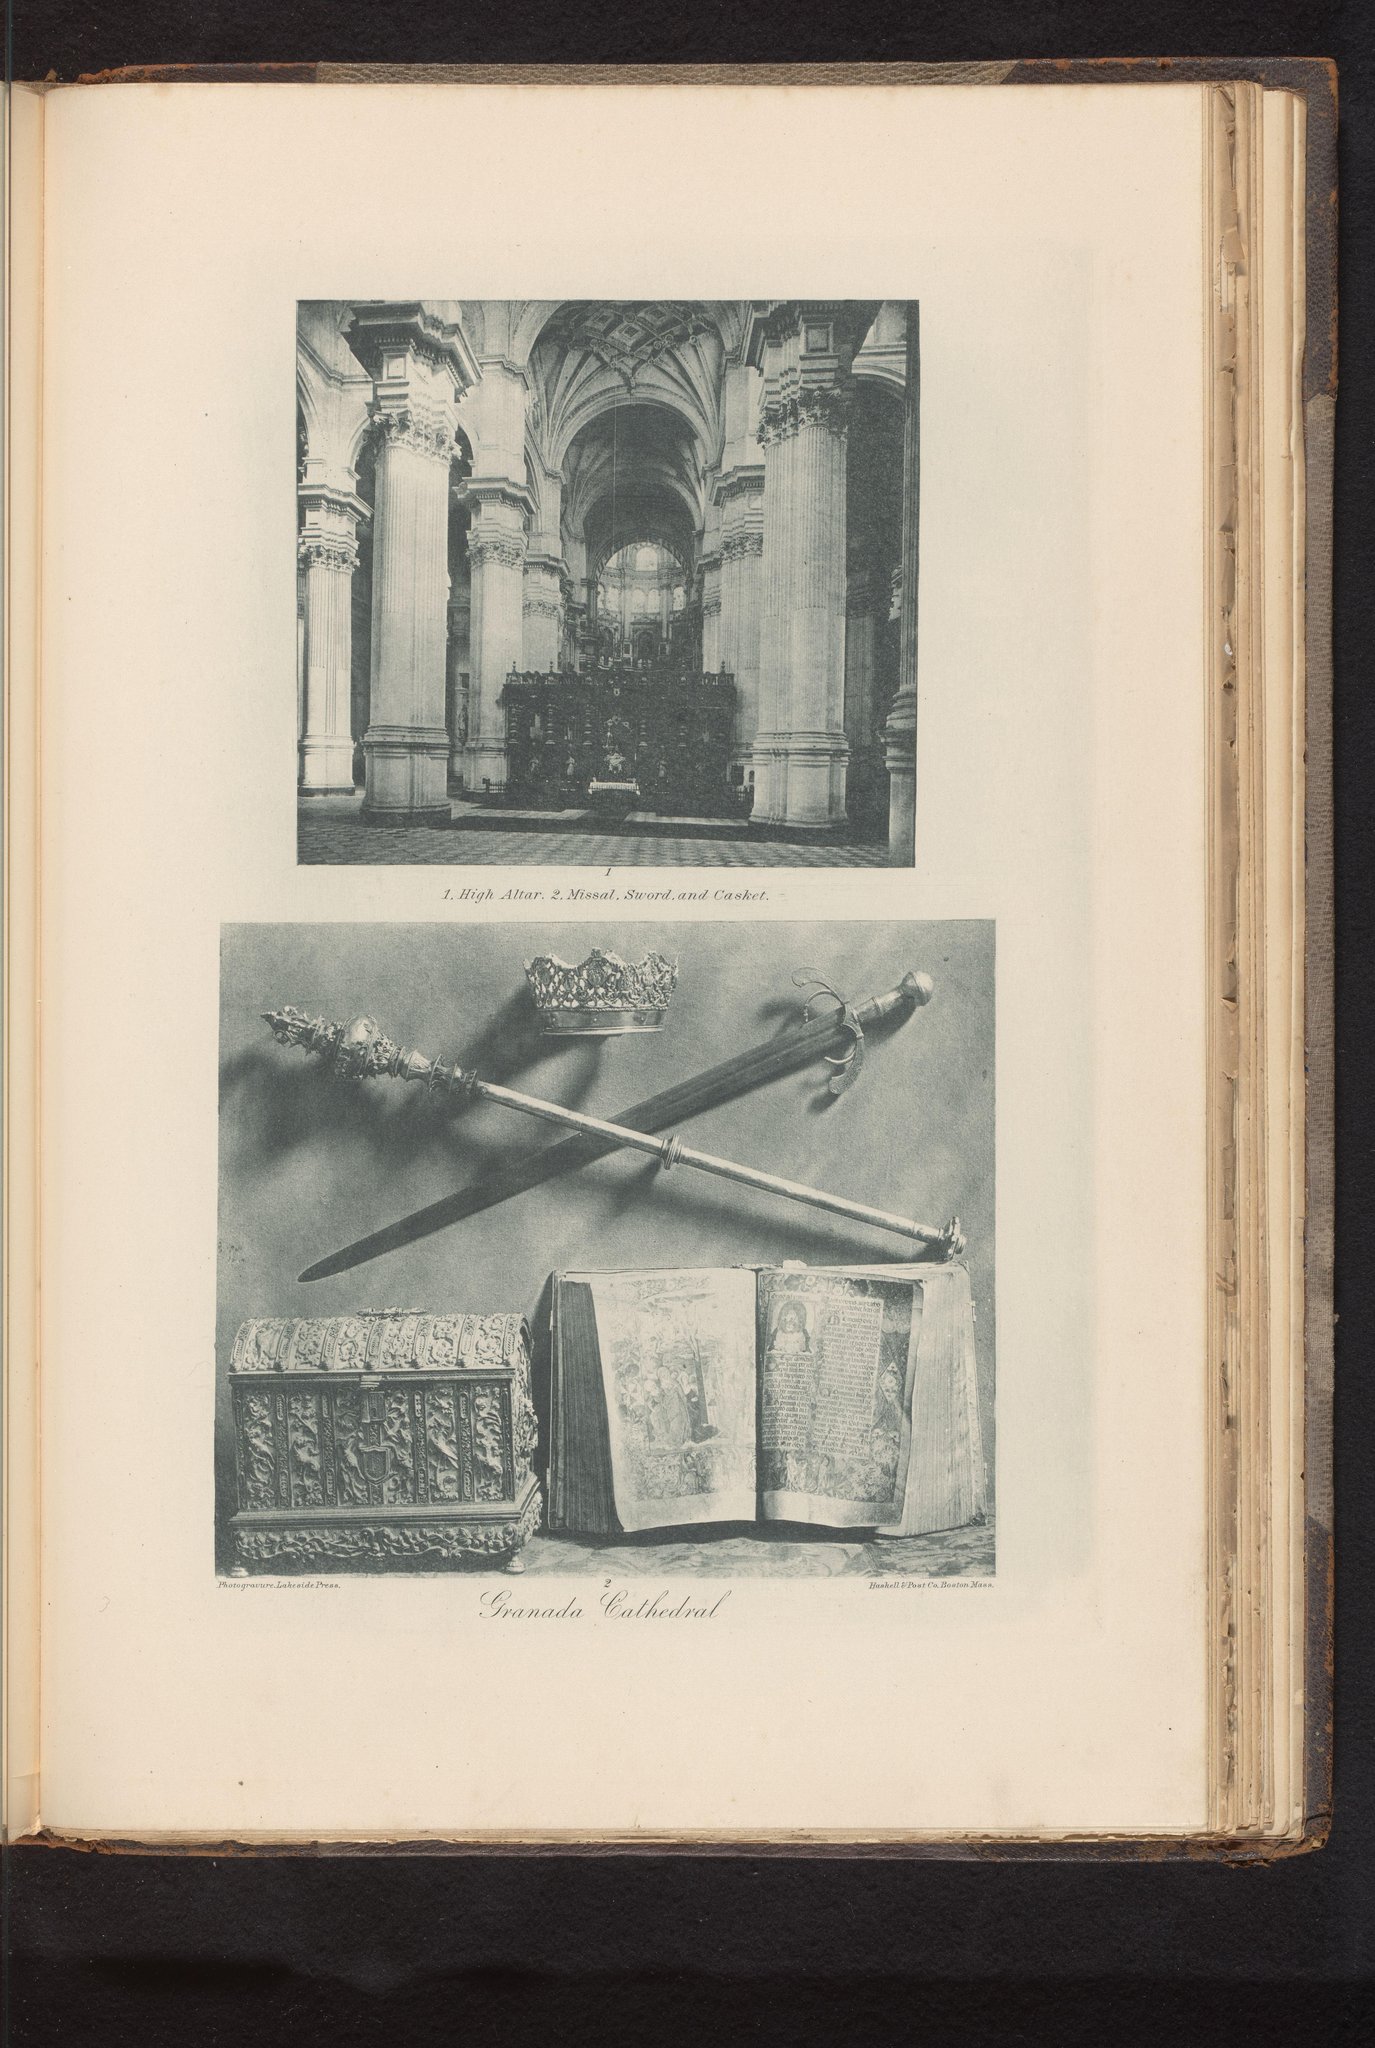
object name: photomechanical print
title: Altaar in de kathedraal van Granada, een misboek, zwaard en kist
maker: Anonymous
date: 1881-1886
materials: paper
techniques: photograph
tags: missal, hacking and thrusting weapons: sword, chest, coffer, altar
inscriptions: inscription: ‘1. High Altar. 2, Missal, Sword, and Casket.’